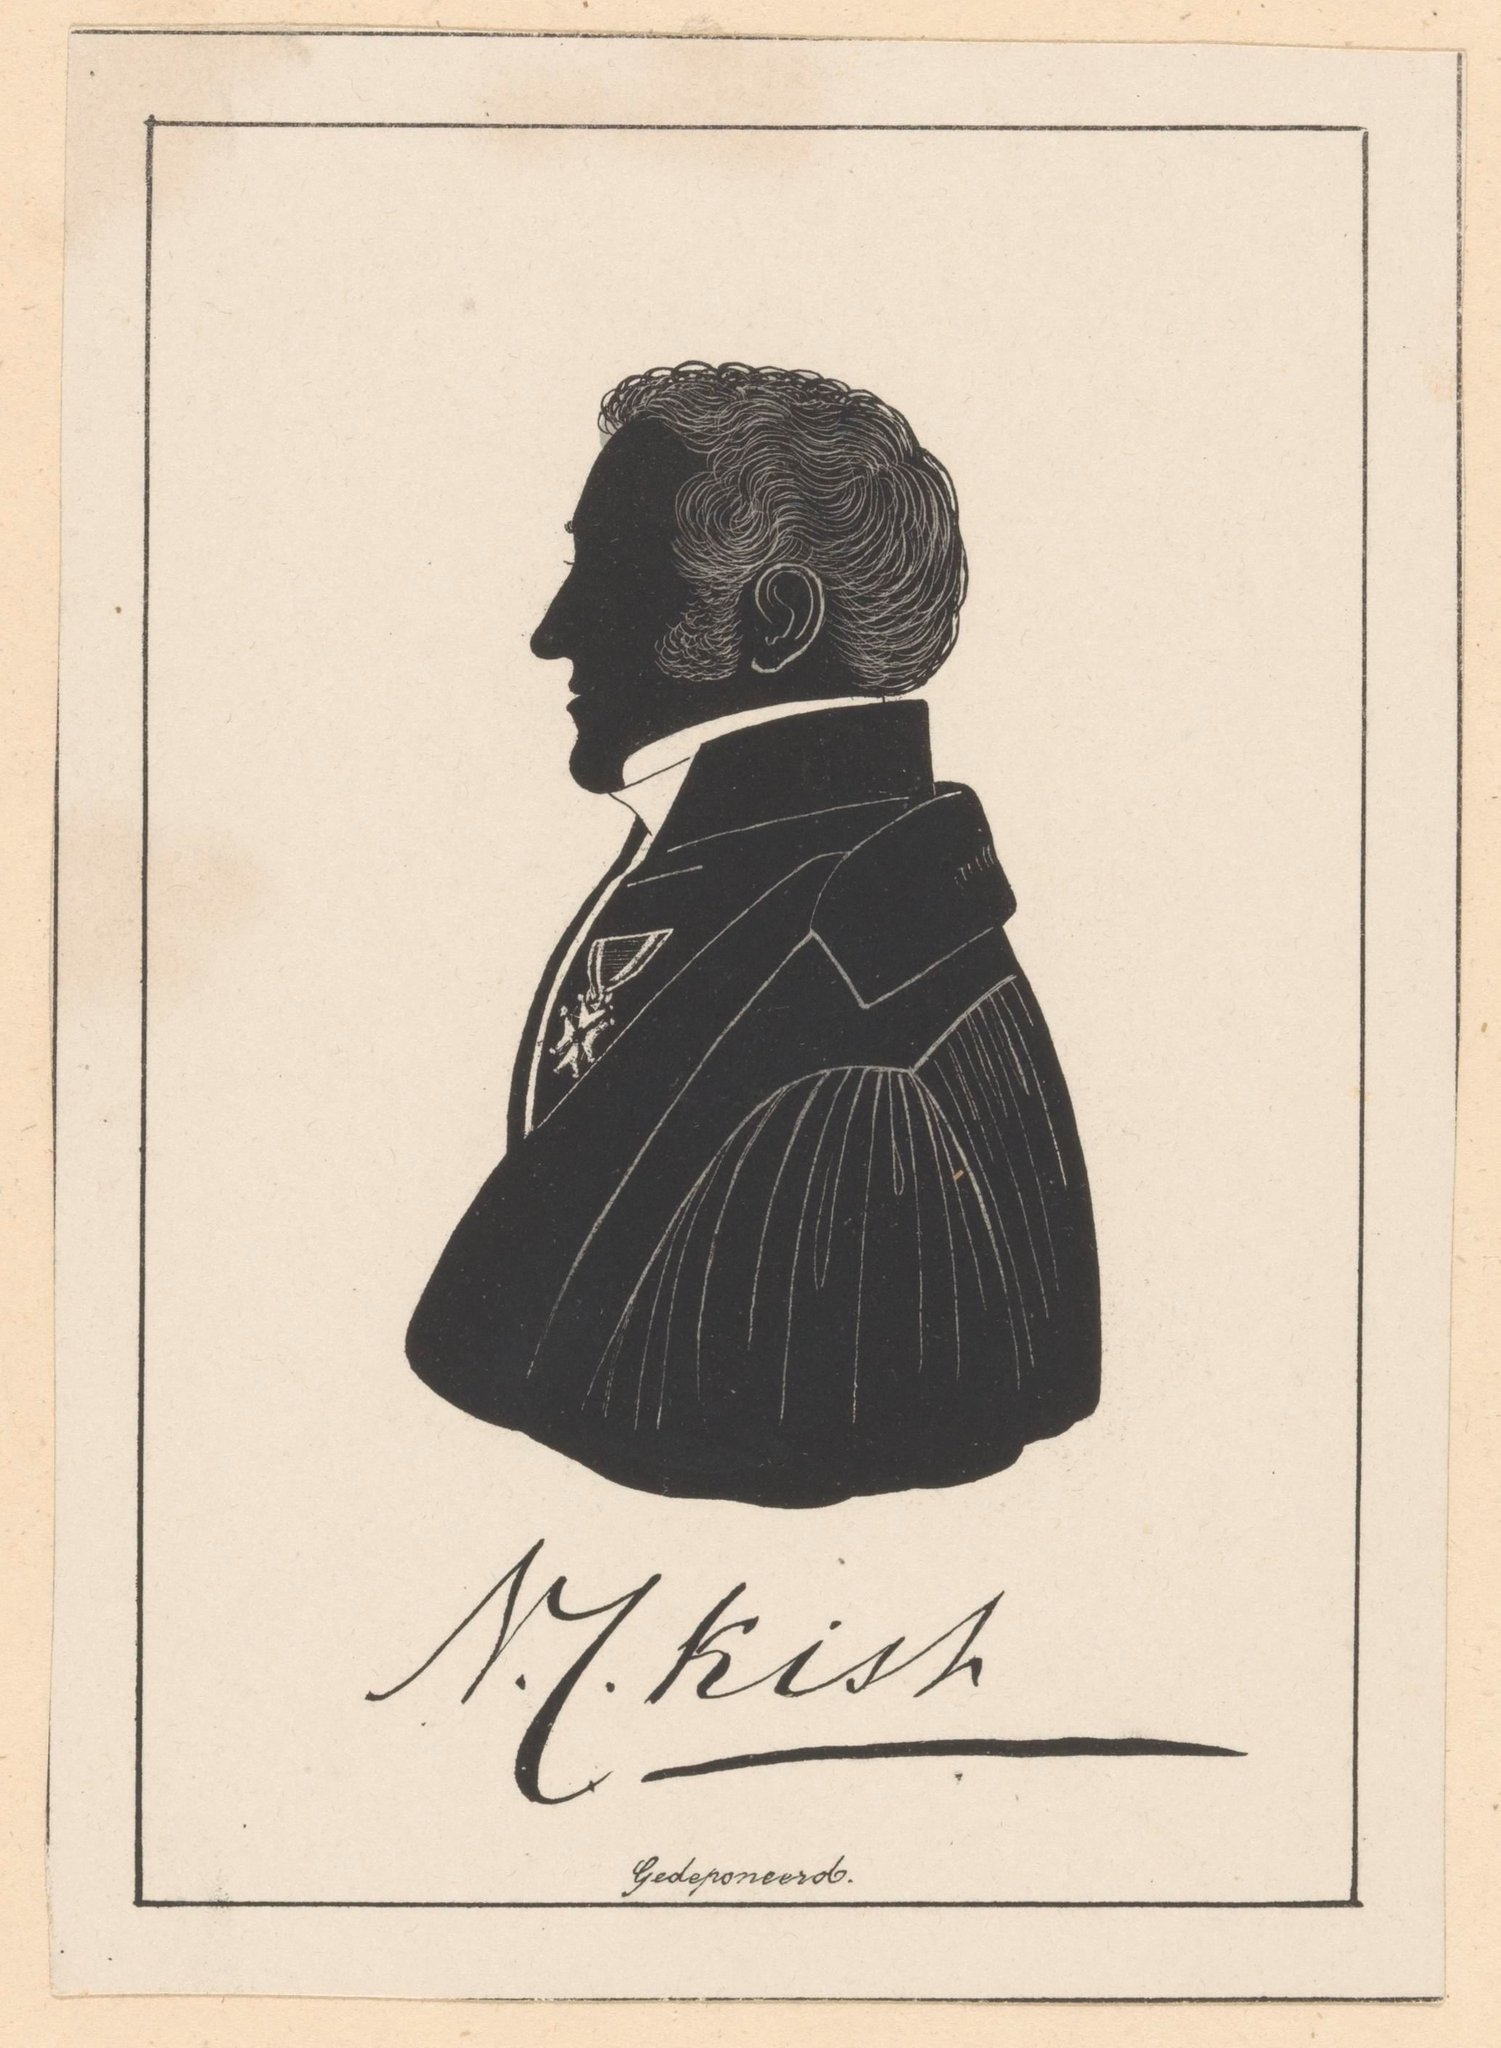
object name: print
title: Silhouetportret van Nicolaas Christiaan Kist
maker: pieter barbiers (iv)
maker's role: painter, print maker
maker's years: 1798-1848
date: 1809-1848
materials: paper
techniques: hand coloring, lithograph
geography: netherlands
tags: leiden, historical persons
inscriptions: : ‘Gedeponeerd.’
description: Onder het portret de signatuur van de geportretteerde.